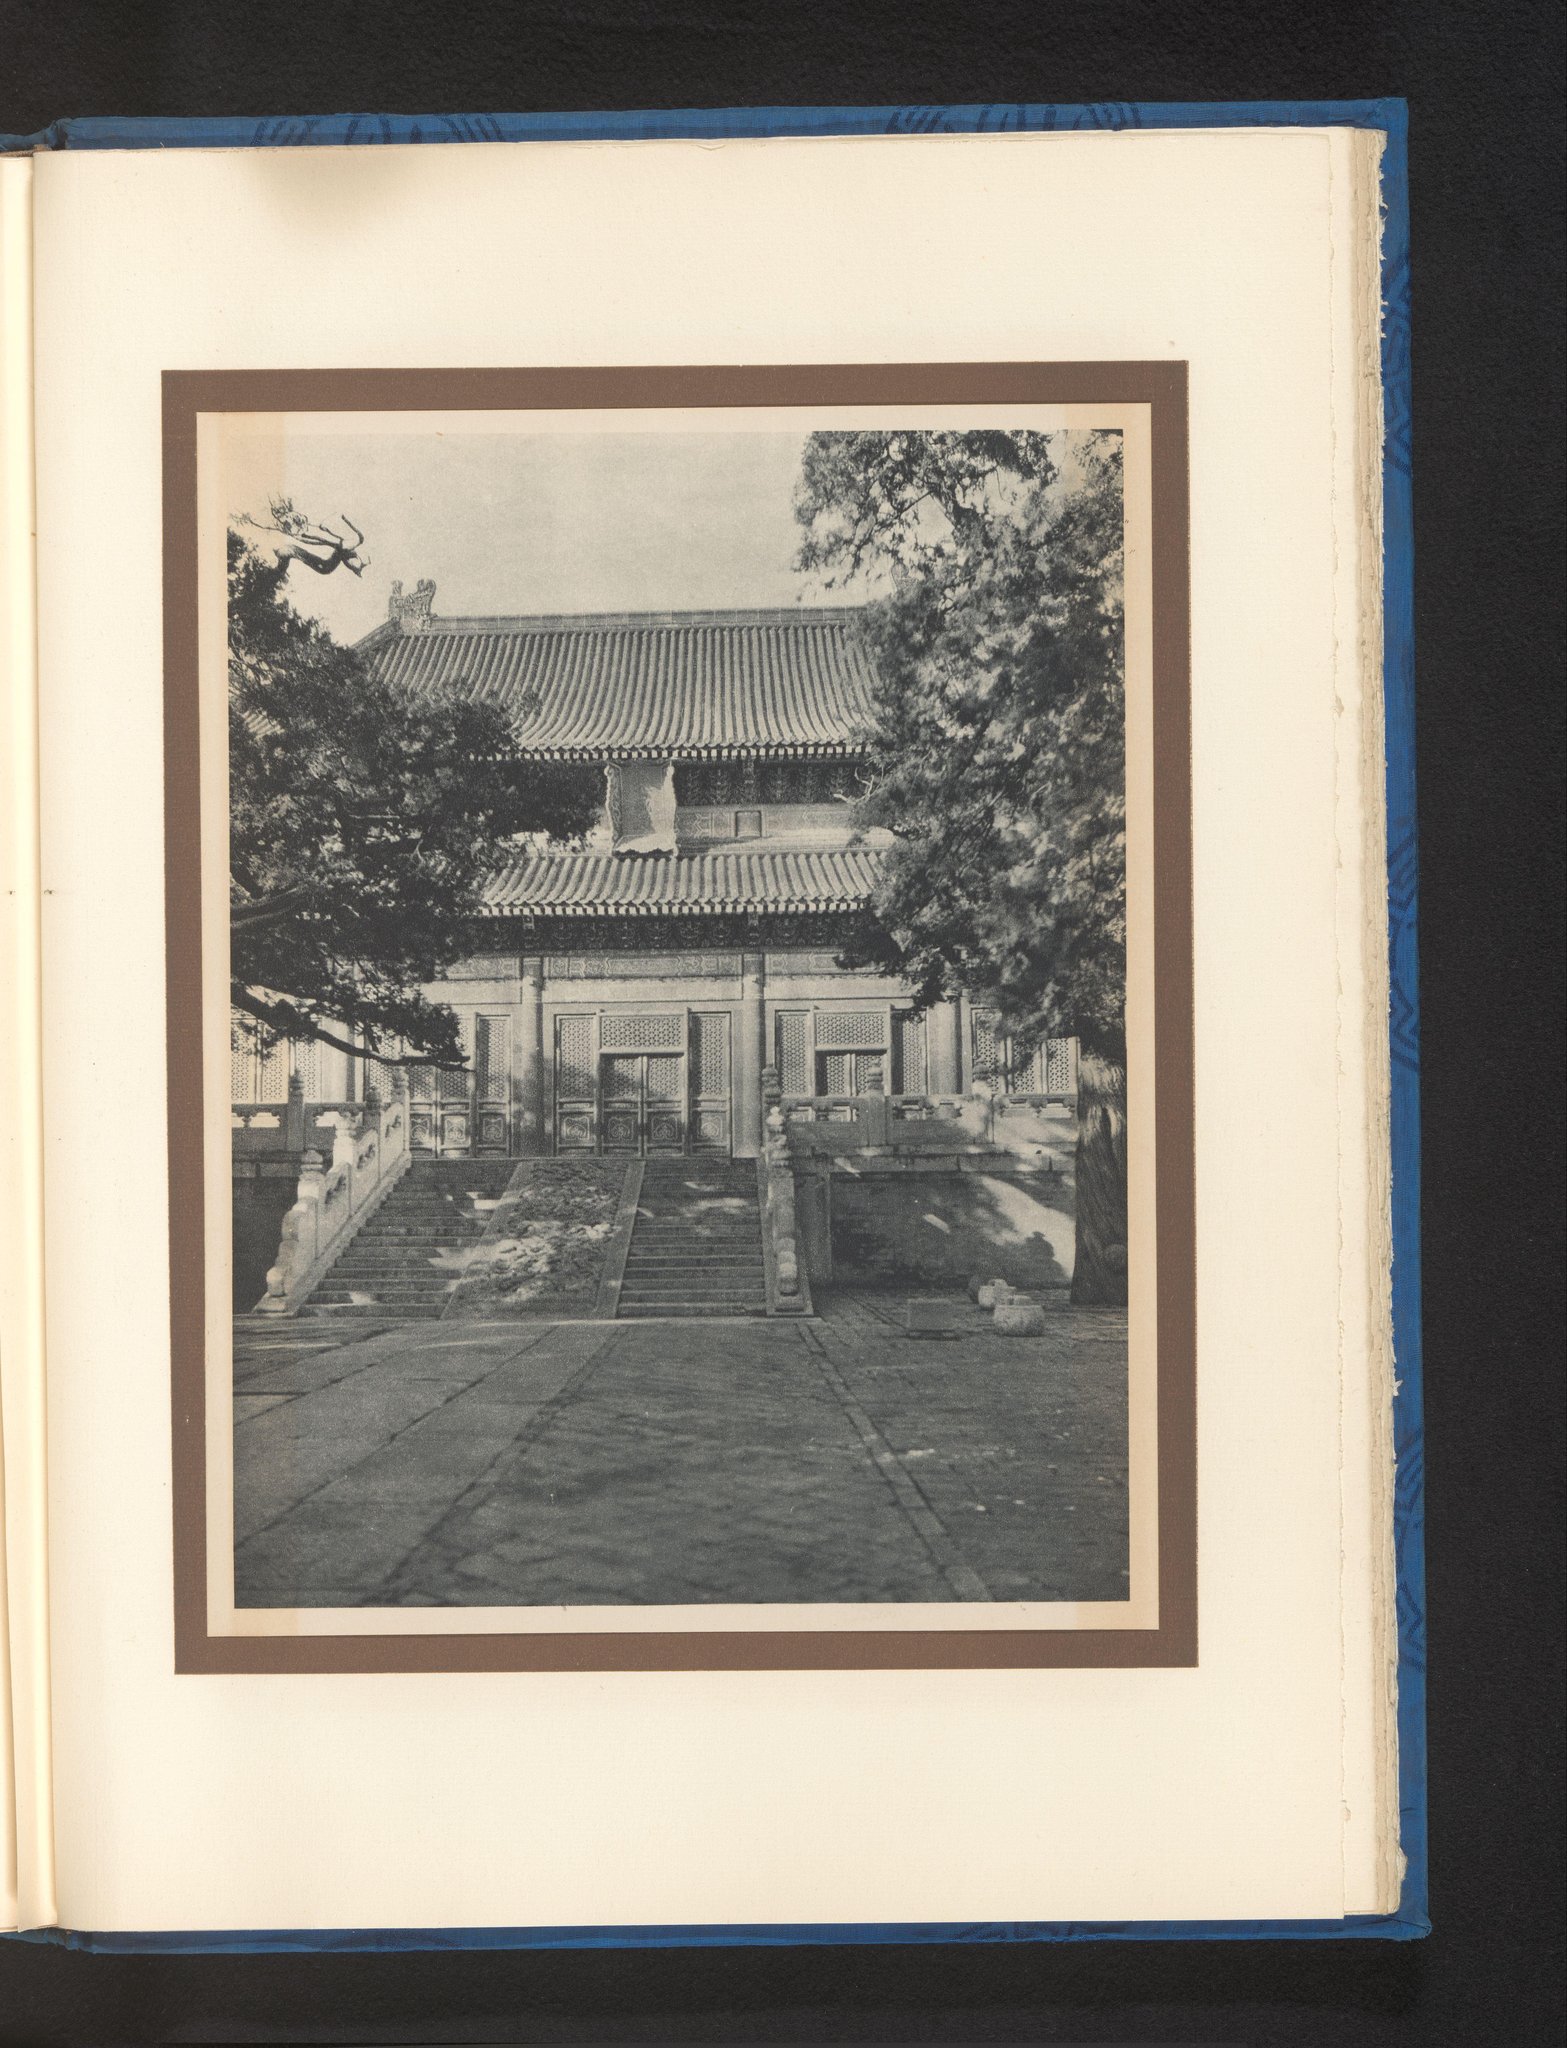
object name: photomechanical print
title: Confuciustempel te Peking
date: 1915-1920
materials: paper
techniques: rotogravure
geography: beijing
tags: temple, shrine ~ non-christian religions